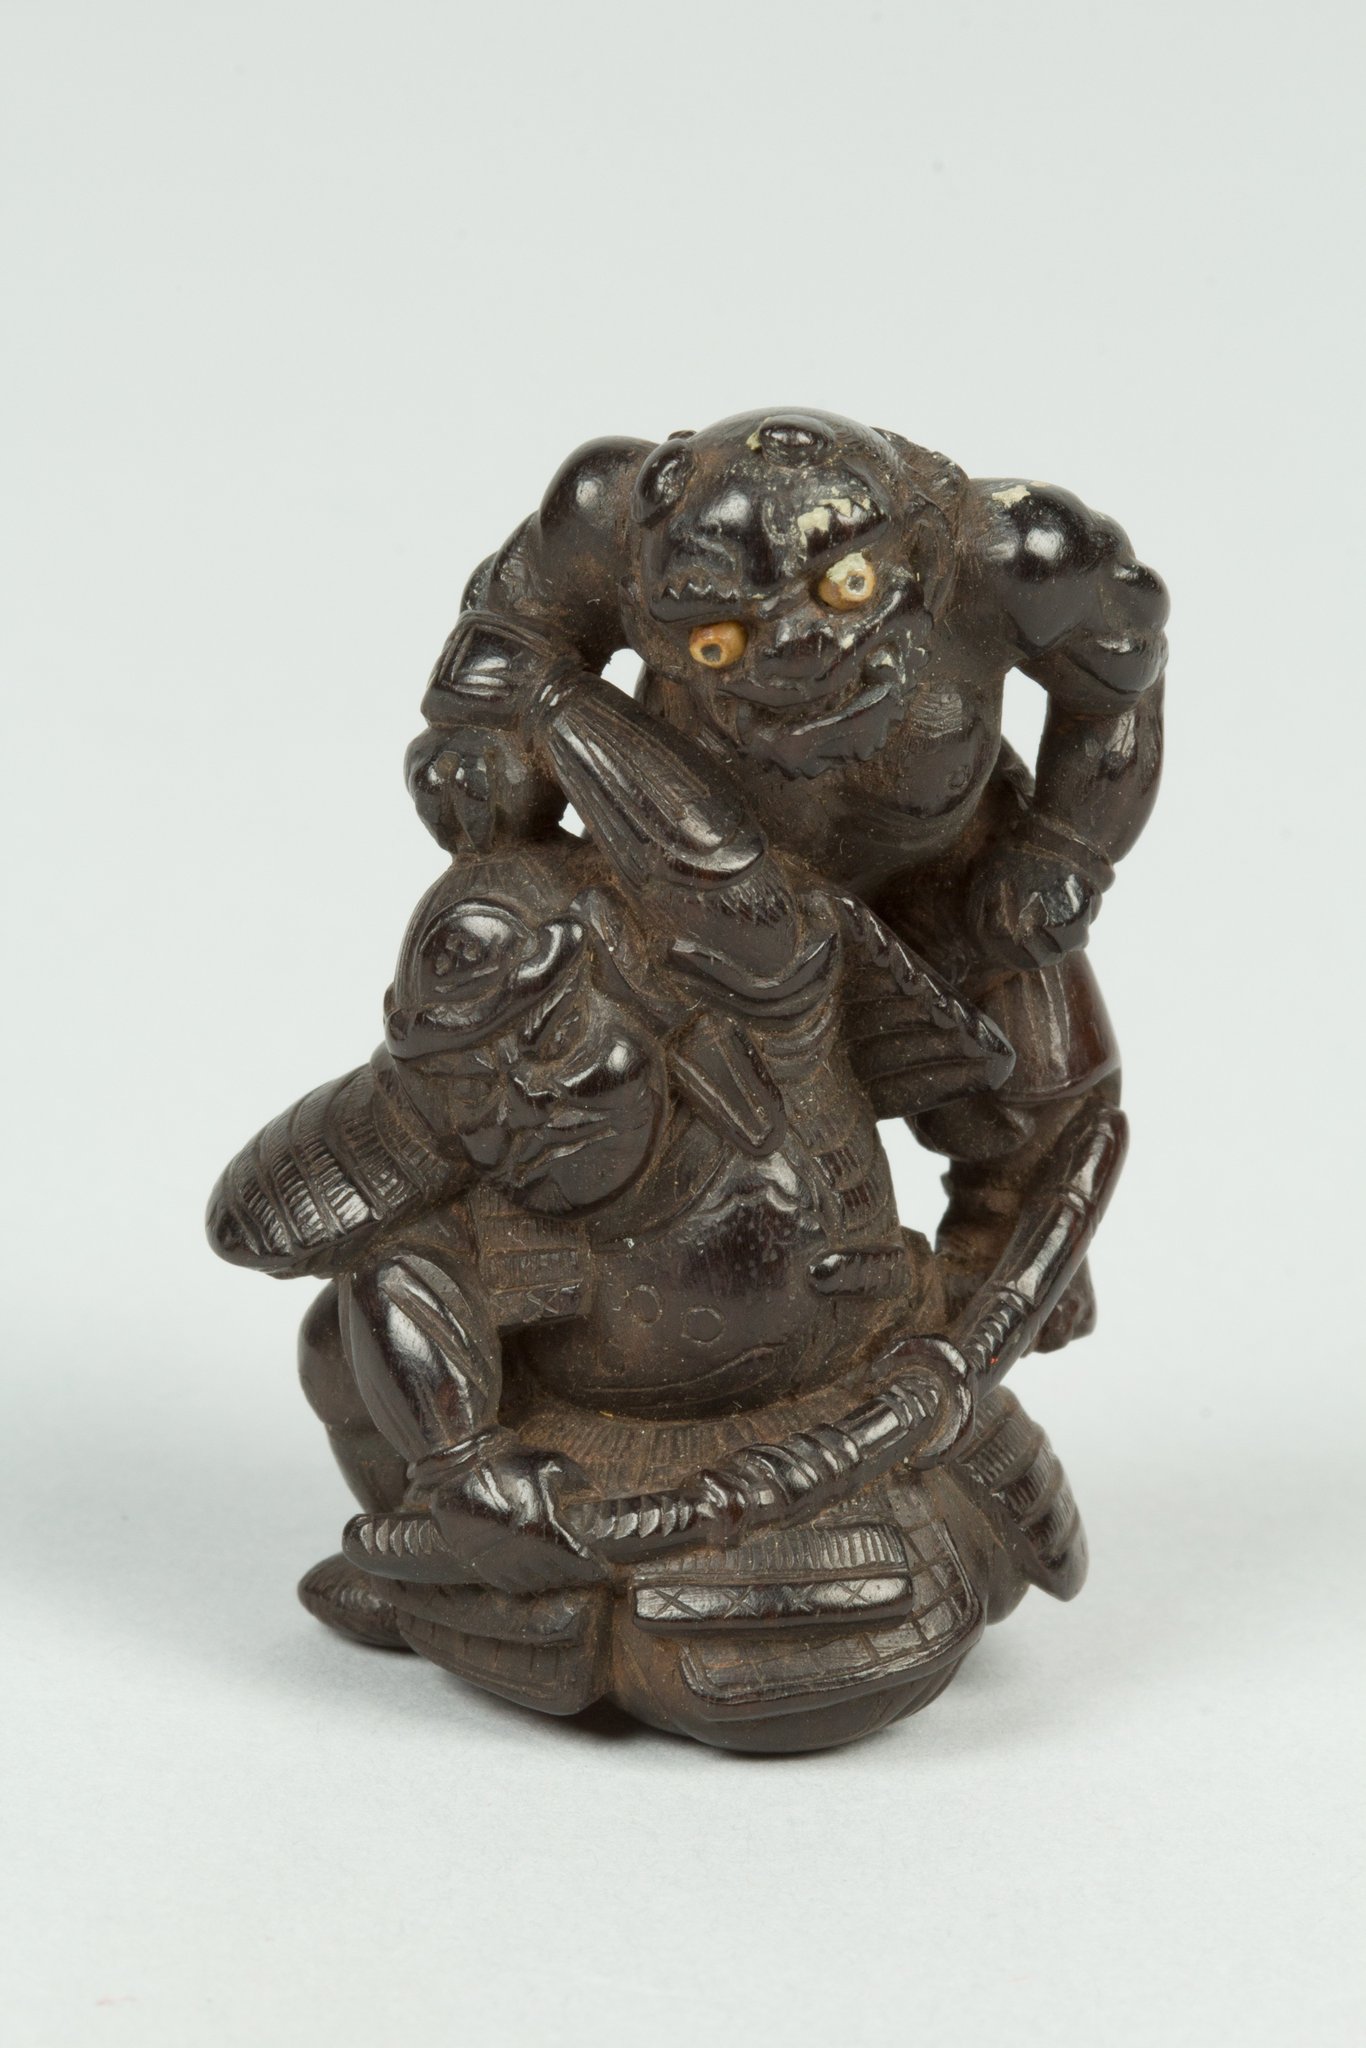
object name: netsuke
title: Netsuke of Demon Attacking a Man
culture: japanese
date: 1801-1900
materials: wood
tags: men,demons